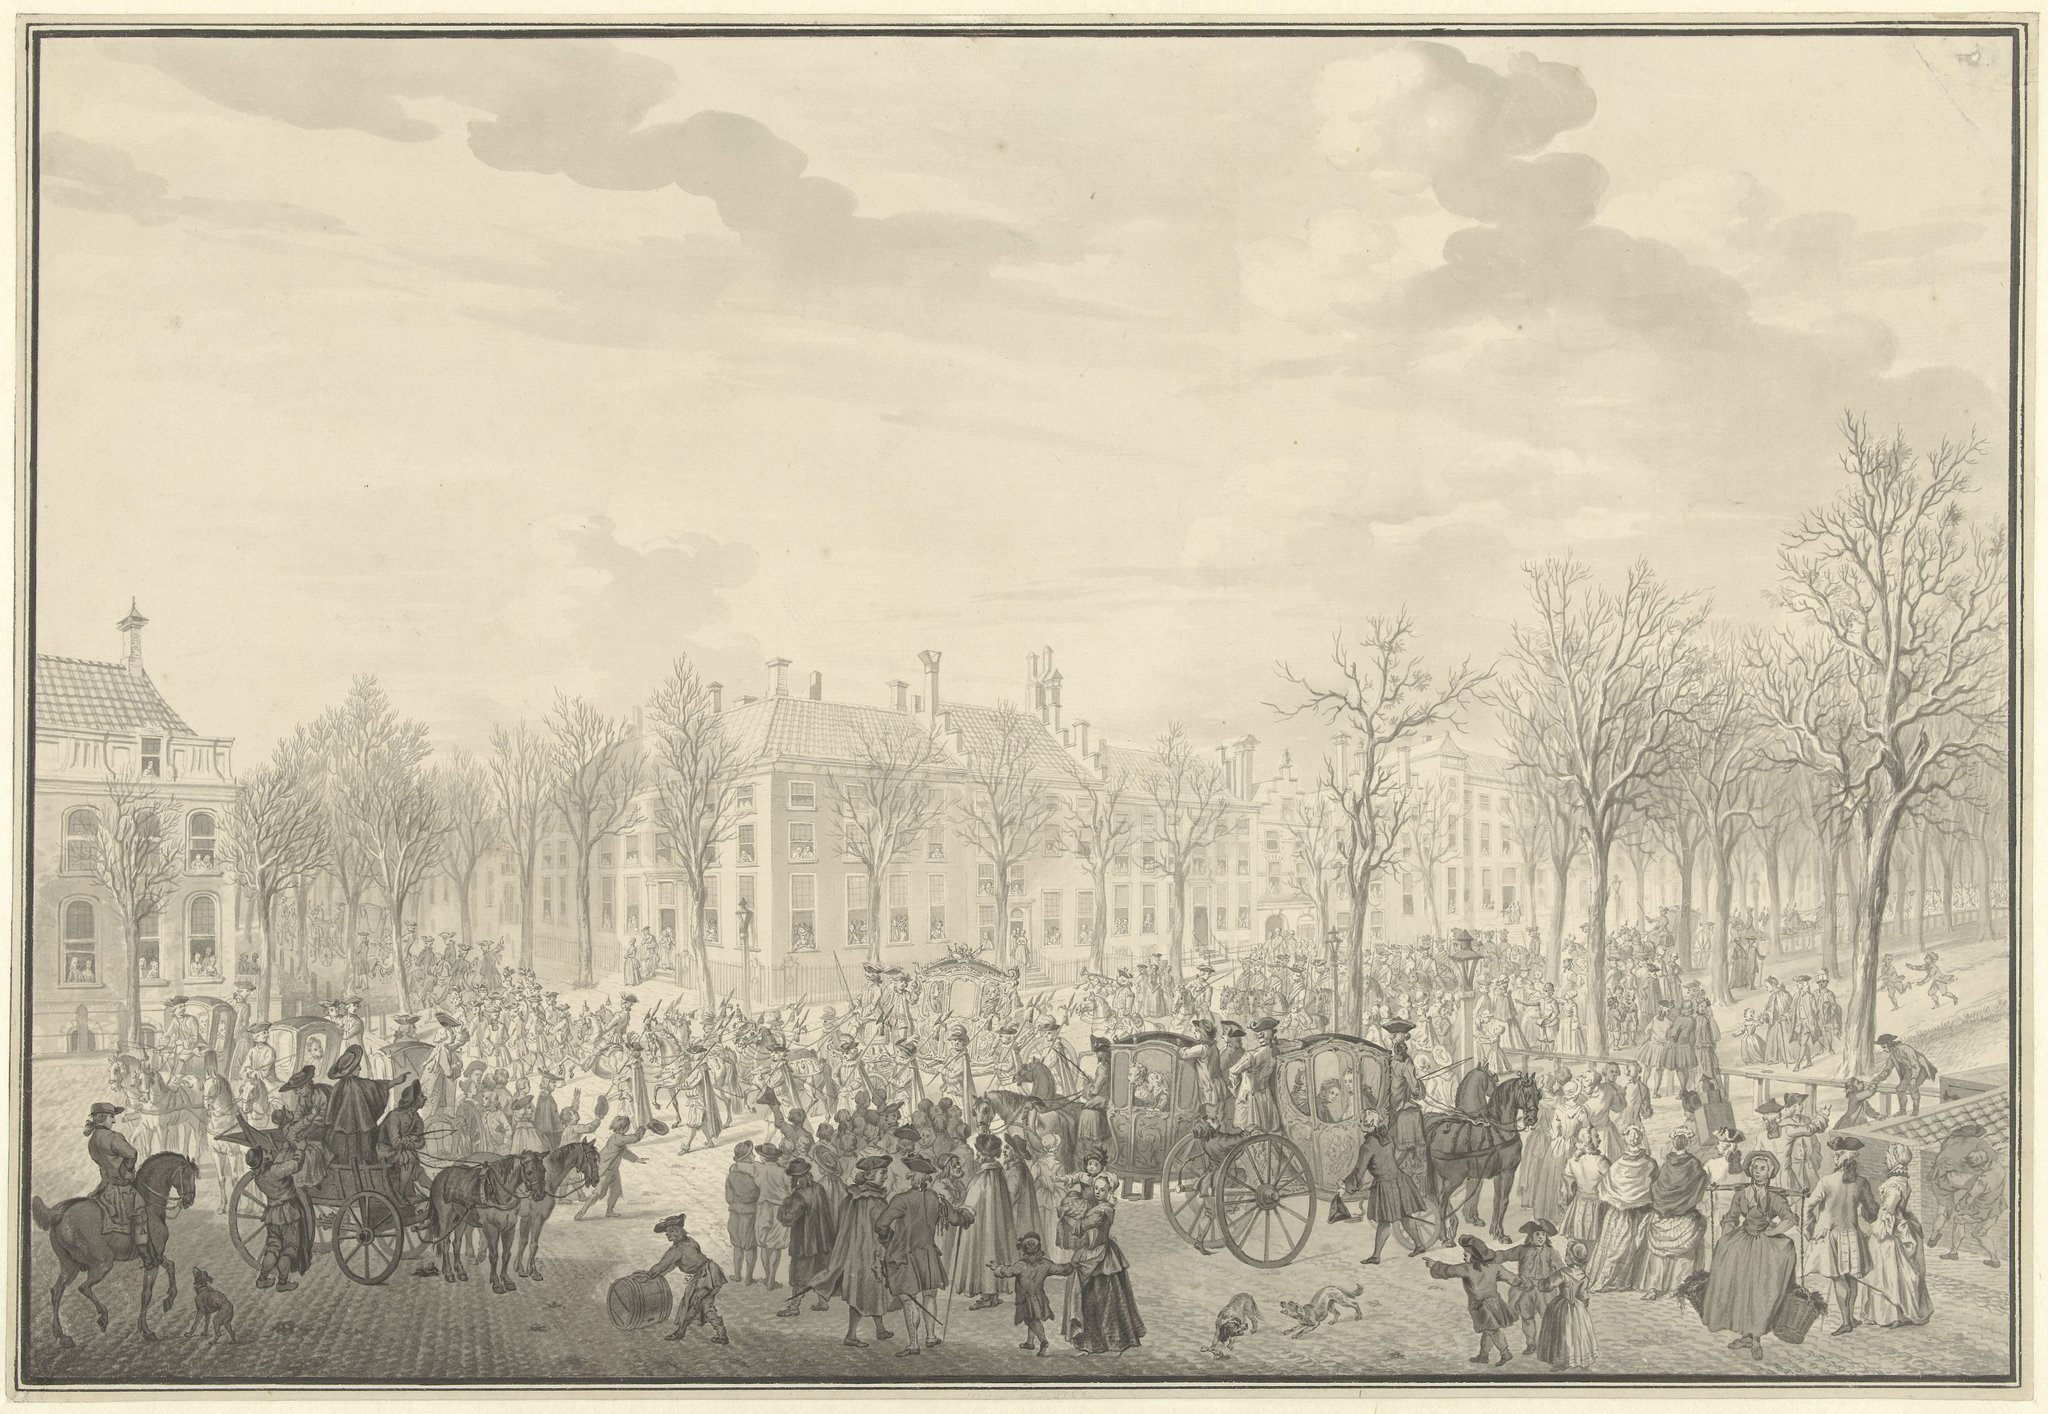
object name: drawing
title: Aankomst van prins Willem V te 's-Gravenhage, 10 november 1762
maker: paulus constantijn la fargue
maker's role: draughtsman, painter, print maker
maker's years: 1729-1782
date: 1762-1782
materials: ink, paper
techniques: brush, pen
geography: northern netherlands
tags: the hague, william v (prince of orange)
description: Wintergezicht met de aankomst van prins Willem V onder grote publieke belangstelling te 's-Gravenhage, 10 november 1762. De koets met de prins rijdt van de Vijverberg de Kneuterdijk op, rechts vooraan het Groene Zoodje.